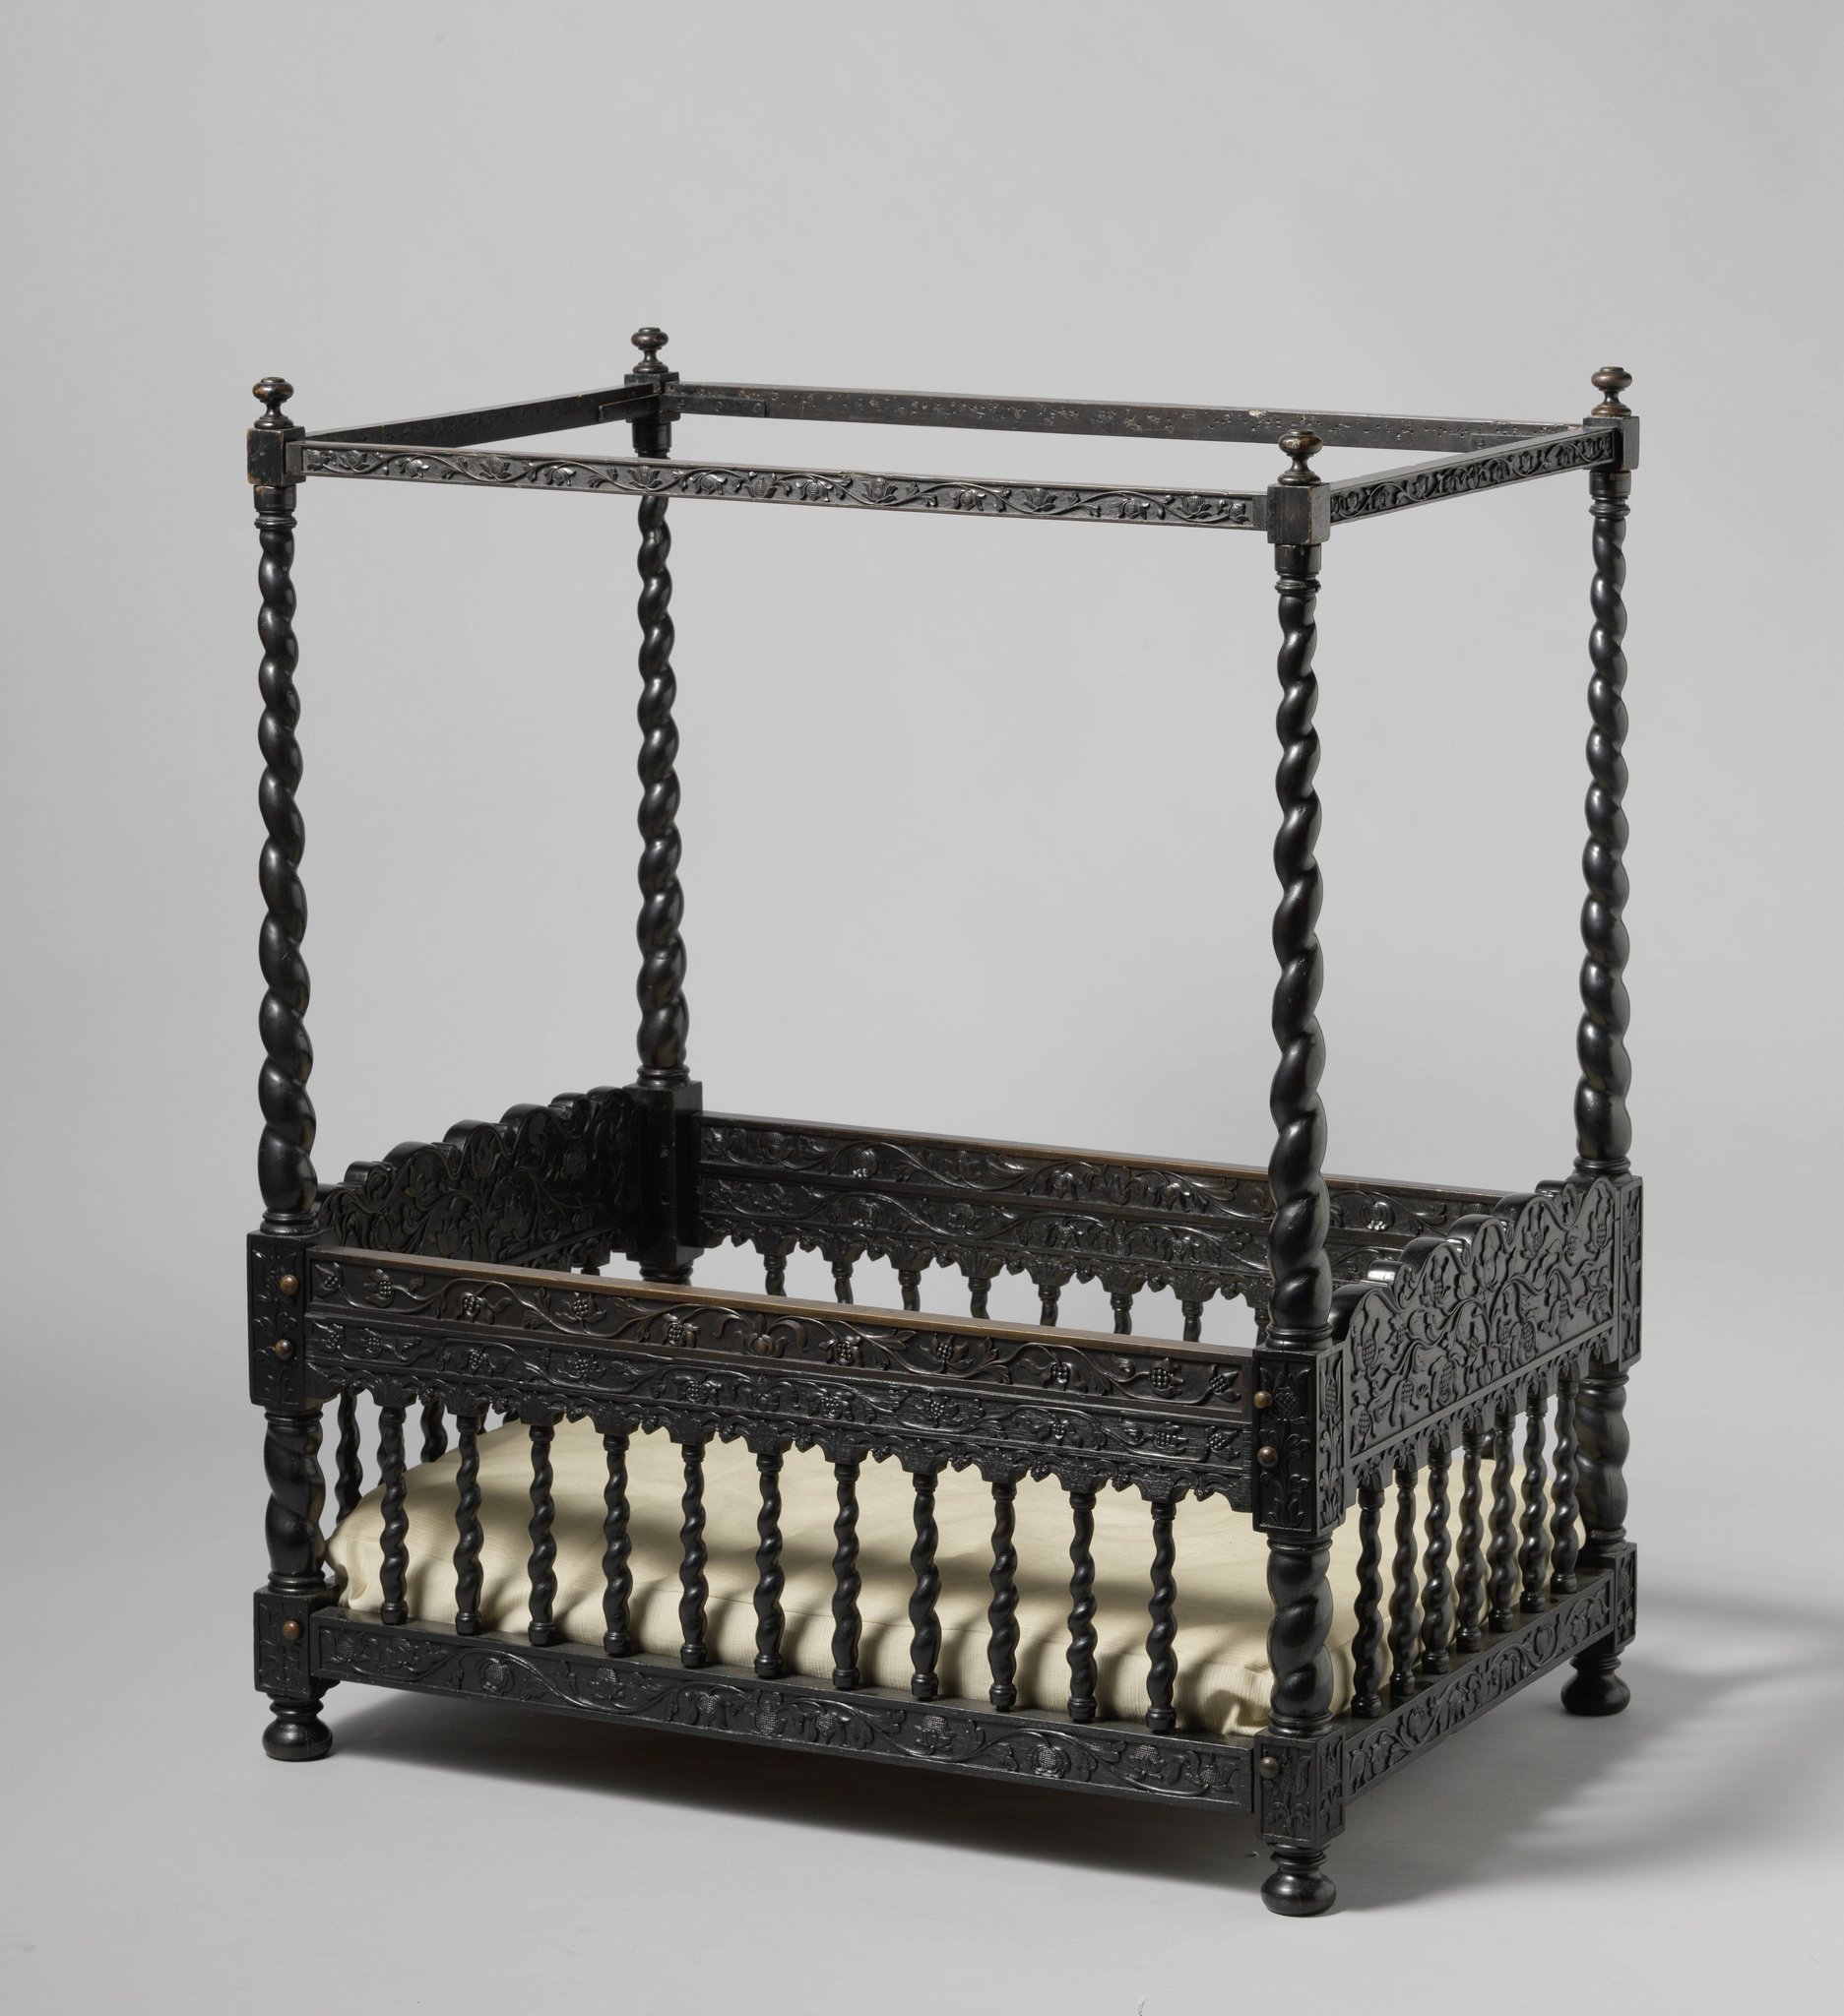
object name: furniture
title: Child’s cot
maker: Anonymous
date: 1650-1700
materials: wood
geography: batavia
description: Ebony furniture with large floral motifs in relief was all the fashion in Batavia in the second half of the seventeenth century. At first these pieces were made in India and imported to Batavia. Later, they were also made in Batavia, often by Indian woodcarvers. The shape of the bed, with its four posts, is European. An insect net was draped over the rail.